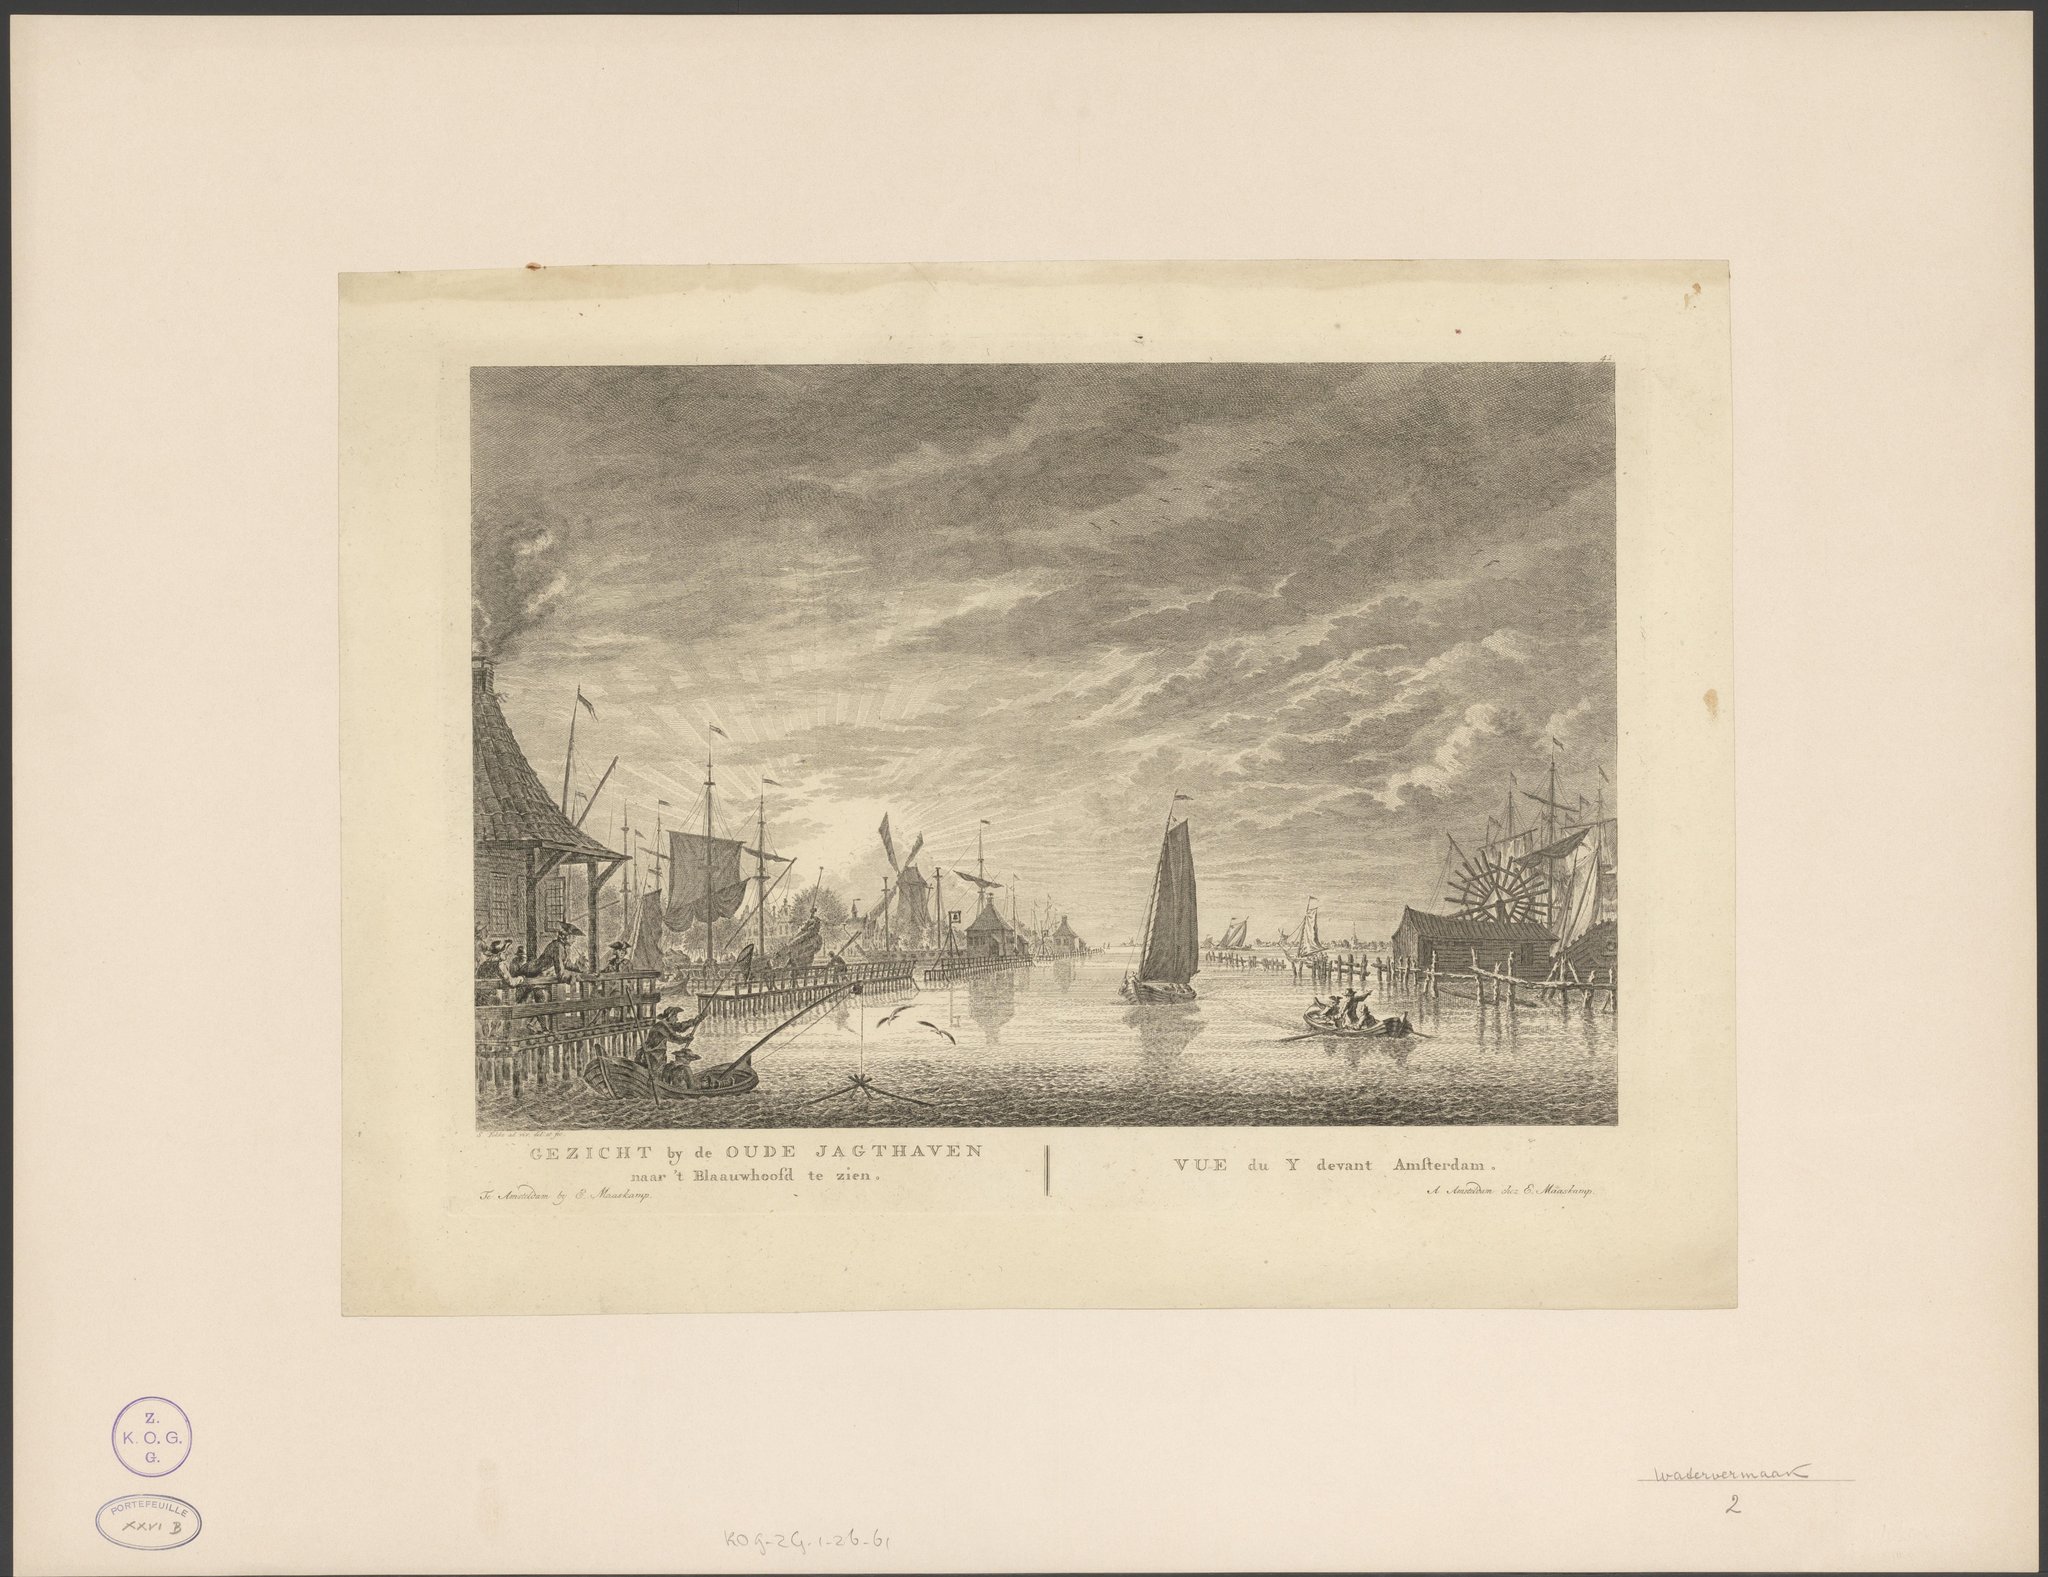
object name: print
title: Gezicht by de Oude Jagthaven naar 't Blaauwhooft te zien / Vue du Y devant Amsterdam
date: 1805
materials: paper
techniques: engraving, etching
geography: amsterdam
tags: harbour, fresh-water fishery, ships (in general), amsterdam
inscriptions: collector's mark, collector's mark: Lugt 1641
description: Deze prent is ook gebruikt in de zogenaamde Atlas van Fouquet.* Pierre Fouquet gaf vanaf 1760 stadsgezichten van Amsterdam - naar tekeningen van verschillende kunstenaars, gemaakt door verschillende prentmakers - uit. Deze prenten werden aanvankelijk los of in series verkocht. Zoals toen gebruikelijk kon de koper de prenten zelf laten inbinden. Hiertoe gaf Fouquet tussen 1778 en 1783 een titelblad, plattegrond en inhoudsopgave van de tot dusver 100 uitgegeven prenten uit (1). Gezien de inhoud afhankelijk was van wat de koper had verzameld verschilt de inhoud van de verschillende bewaarde Fouquetatlassen onder deze titel sterk. Ook zijn er exemplaren bekend waar tevens andere prenten aan zijn toegevoegd. Omdat er behoefte bleek aan uitleg bij de platen werd in 1783 een nieuwe versie van de atlas uitgegeven, aangevuld met tekst en twee prenten. De aangegeven volgorde veranderde maar de platen van de al eerder uitgegeven prenten bleven ongewijzigd. Deze uitgave werd in opdracht van Fouquet gedrukt bij Daniël Jean Changuion en Petrus den Hengst (2). Een tiental platen werd bijgewerkt en verscheen, met nieuw impressum, in het vervolg van Wagenaars geschiedenis van Amsterdam, uitgeven door Petrus Conradi en Folkert van der Plaats (3). Een aantal jaar na het overlijden van Fouquet kwam Evert Maaskamp met een nieuwe uitgave van de atlas, met verbeterde tekst en toevoeging van twee prenten. Op alle platen verwijderde hij het oude en liet hij zijn eigen impressum zetten (4). * Onder de Atlas van Fouquet of Fouquetatlas verstaan we de hieronder vermelde publicaties (1), (2) en (4). (1). Afbeeldingen van de wyd-vermaarde koopstad Amsterdam benevens des zelvs voornaamste gebouwen en gezigten alle naar het leeven getekend / Receuil des edifices les plus considerables et des plus belles vues, de la fameuse ville d'Amsterdam, dessinées d'après nature. Amsterdam: Pierre Fouquet, 1778-1783. (2). Nieuwe atlas, van de voornaamste gebouwen en gezigten der stad Amsterdam, met derzelver beknopte beschryvingen. 2 delen. Amsterdam: Daniël Jean Changuion en Petrus den Hengst [in opdracht van Pierre Fouquet], 1783. (3). Stijl, Simon. Amsterdam, in zyne geschiedenissen, voorregten, koophandel, gebouwen, kerkenstaat, schoolen, schutterye, gilden en regeeringe, beschreeven. Om te dienen ten vervolge op het werk van Jan Wagenaar (…). 10 delen. Amsterdam en Harlingen: Petrus Conradi en Folkert van der Plaats, 1788-1801. (4). Nieuwe atlas, van de voornaamste gebouwen en gezigten der stad Amsterdam. Met derzelver beknopte beschryvingen. Amsterdam: Evert Maaskamp, 1805.